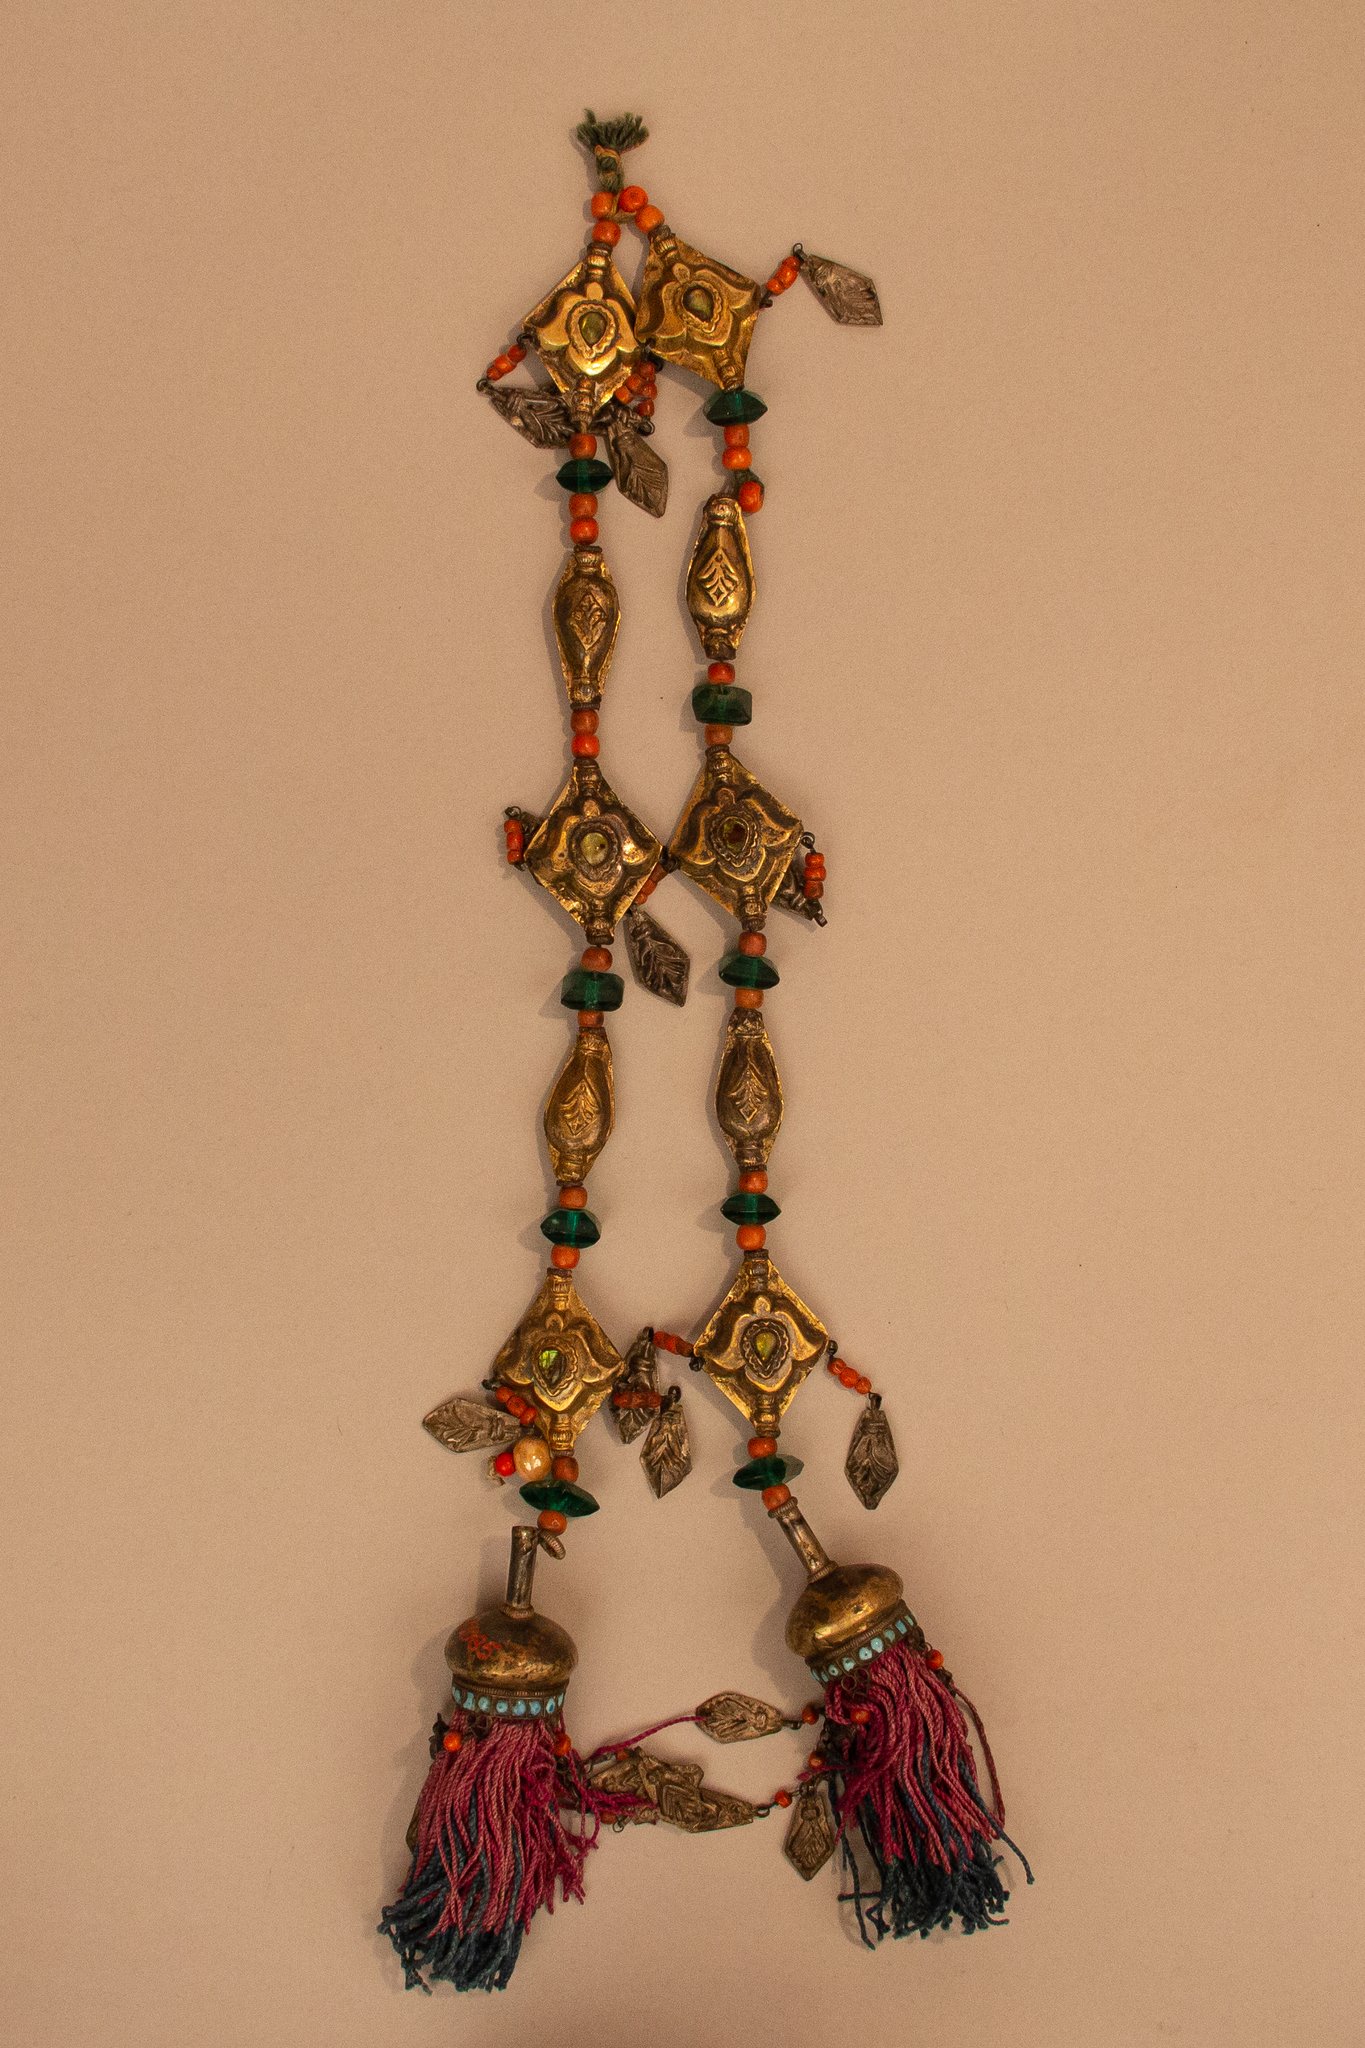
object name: ornament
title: Hair Ornament [or Plait Ornament]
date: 1801-1900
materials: coral, glass, gold, silk, silver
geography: uzbekistan